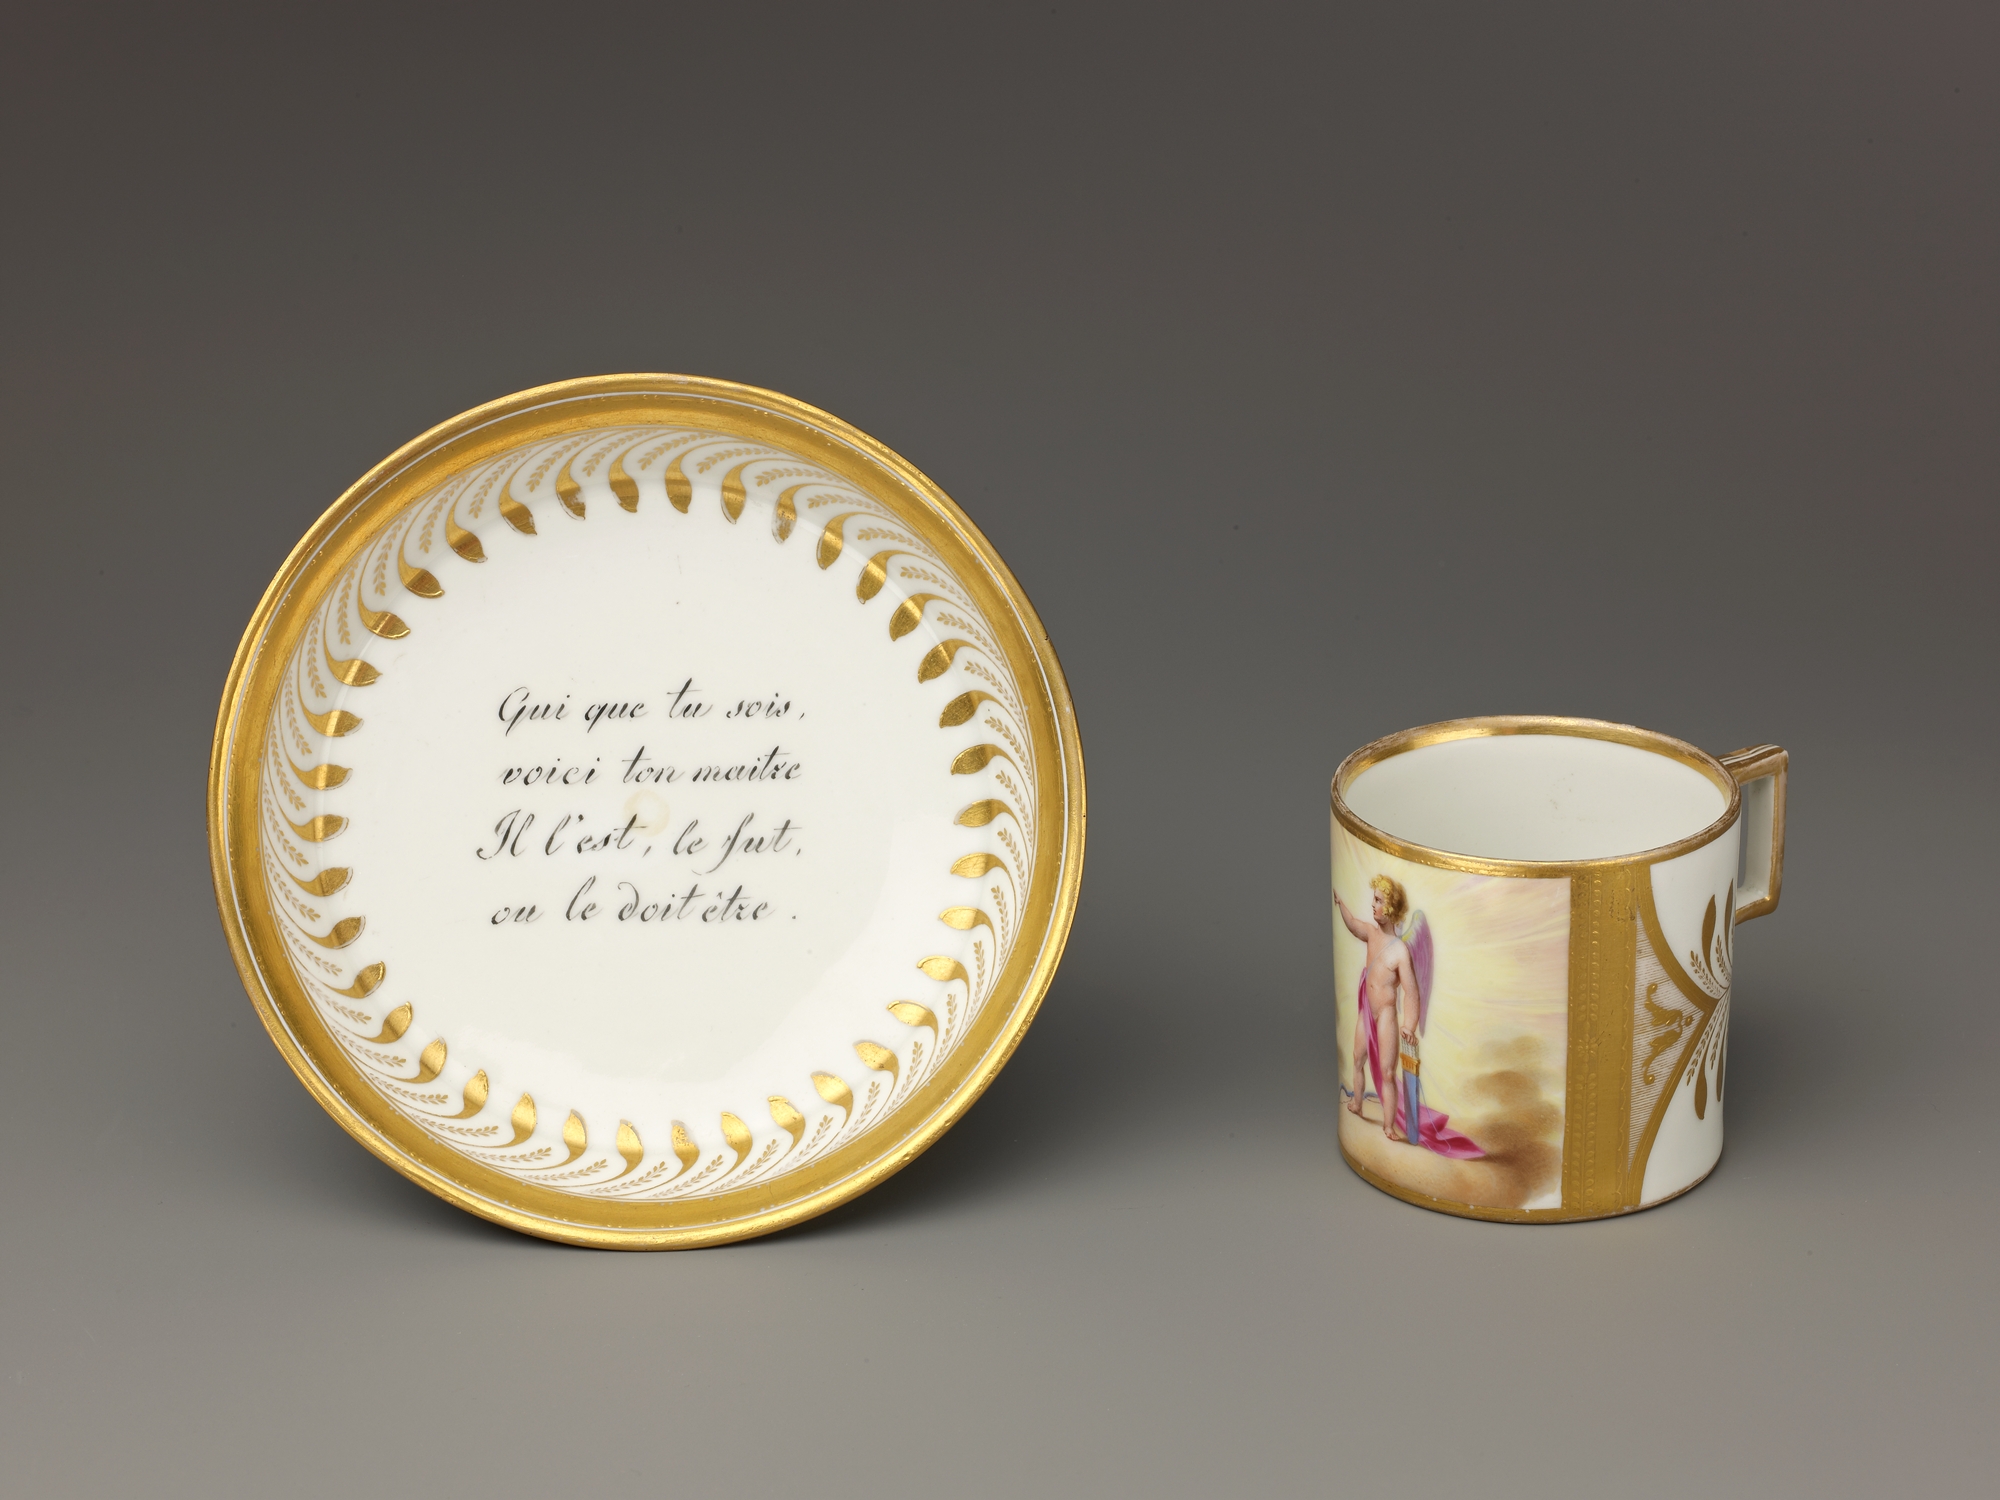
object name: cup and saucer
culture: austrian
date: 1806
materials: hard paste porcelain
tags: cupid